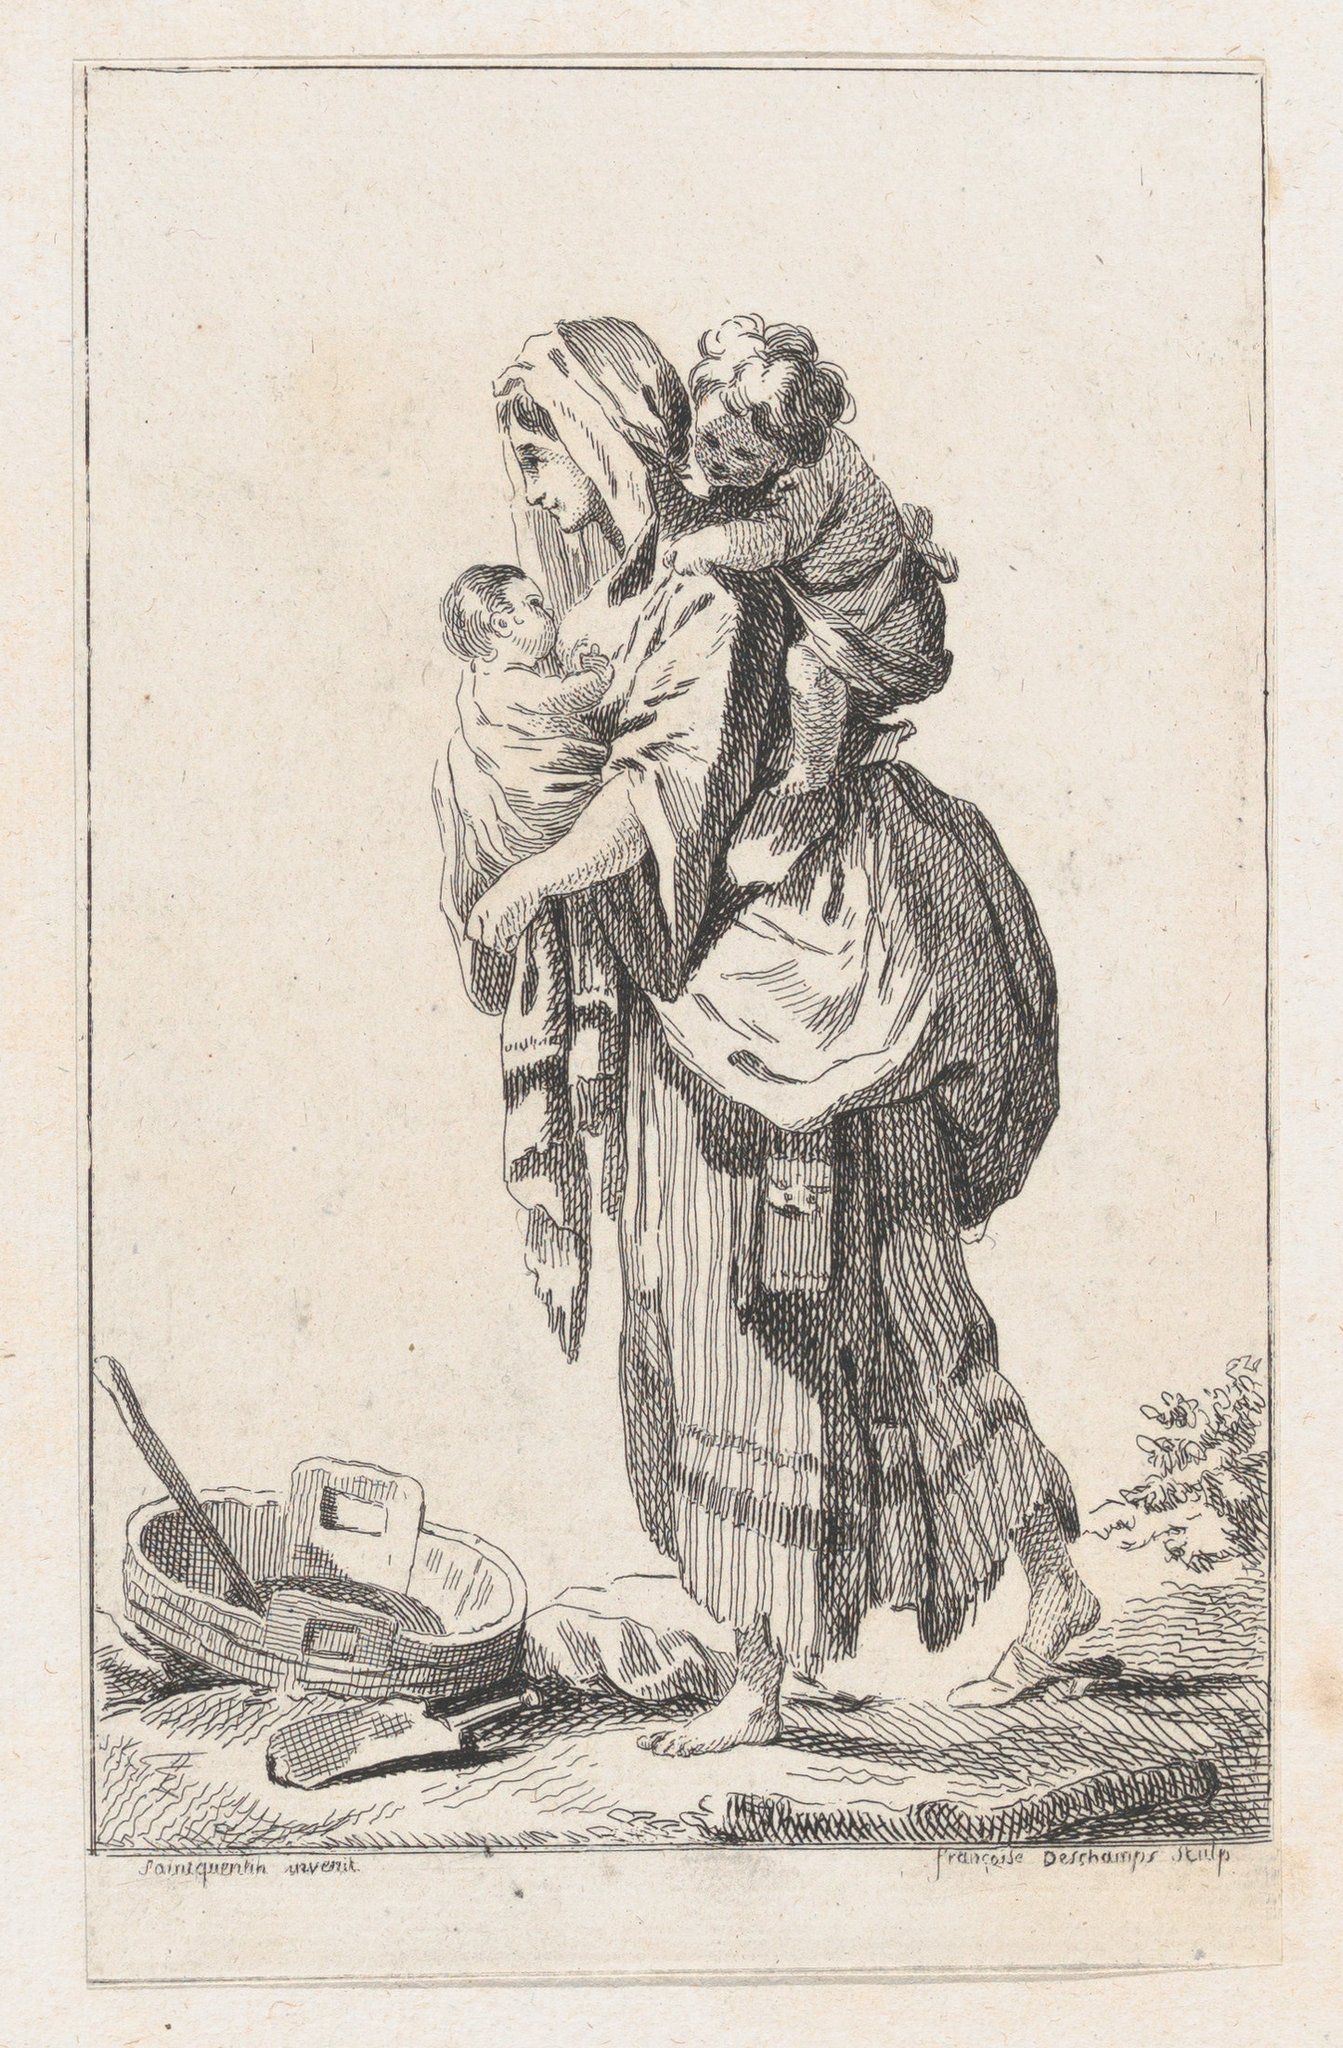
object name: print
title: Peasant Woman with Two Children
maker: catherine-francoise beauvarlet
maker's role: artist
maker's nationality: french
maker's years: 1737-1769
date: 1758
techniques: etching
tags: infants,women